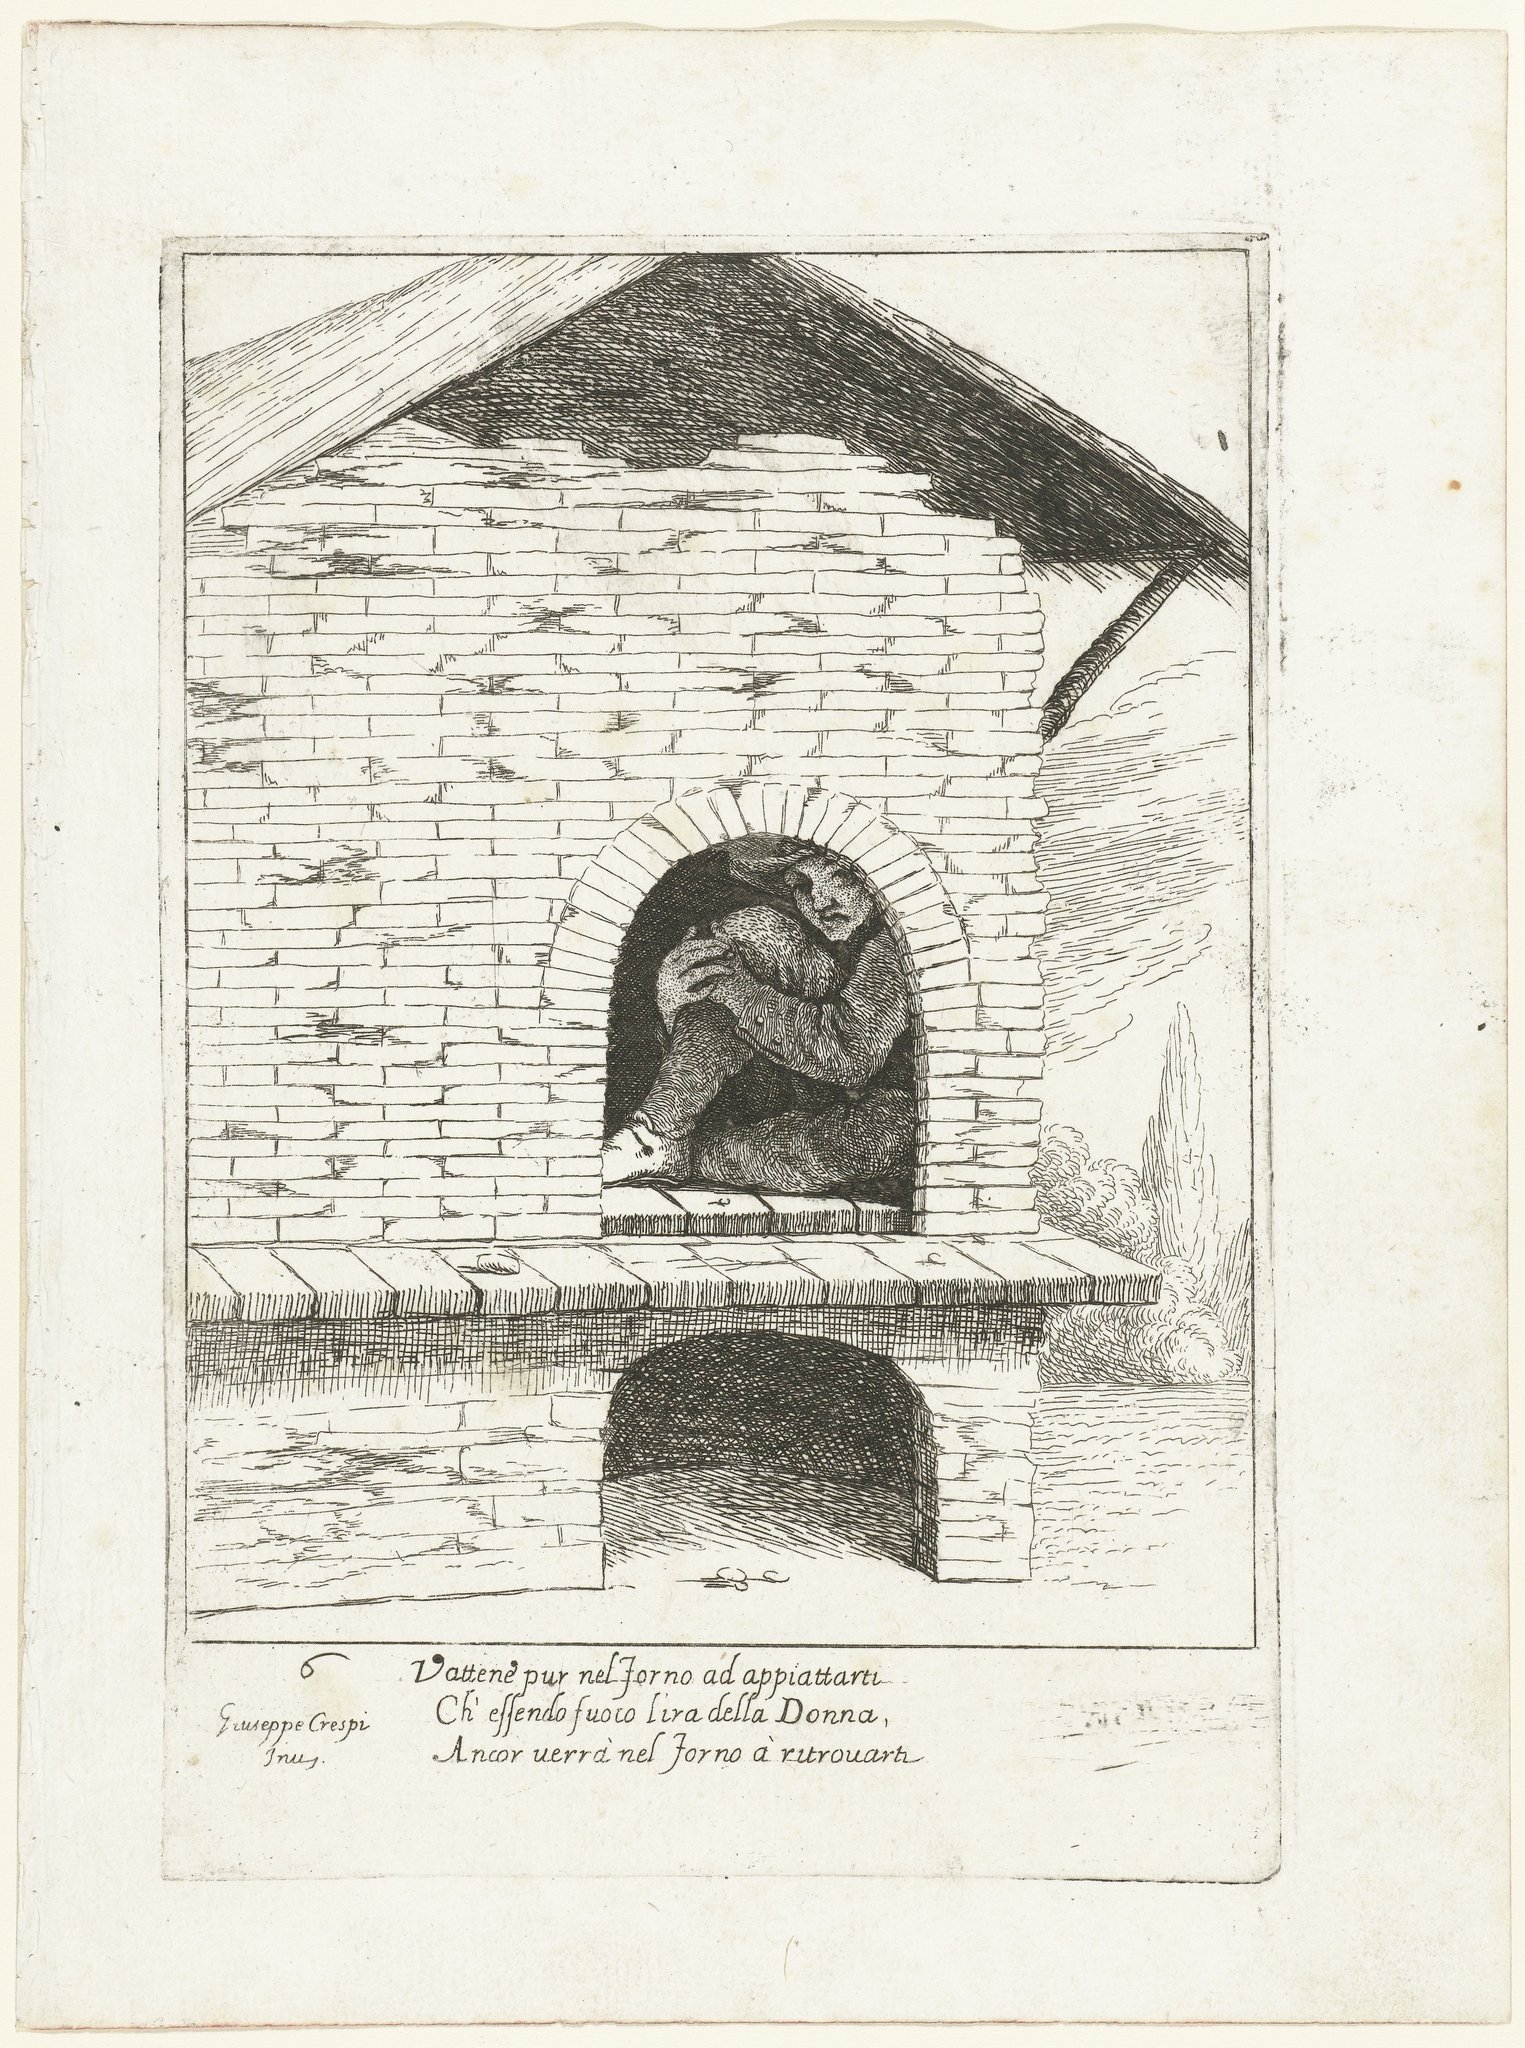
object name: print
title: Bertoldo verstopt zich in een oven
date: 1710-1715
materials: paper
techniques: etching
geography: italy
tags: literary characters and objects, fire, oven, furnace ~ interior of industrial structure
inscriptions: collector's mark: Lugt 2228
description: Bertoldo zit verstopt in een stenen houtoven. Onder de voorstelling een drieregelig rijmpje in het Italiaans. Prent uit een reeks van zes met de belevenissen van Bertoldo, onderdeel van een serie van twintig prenten.